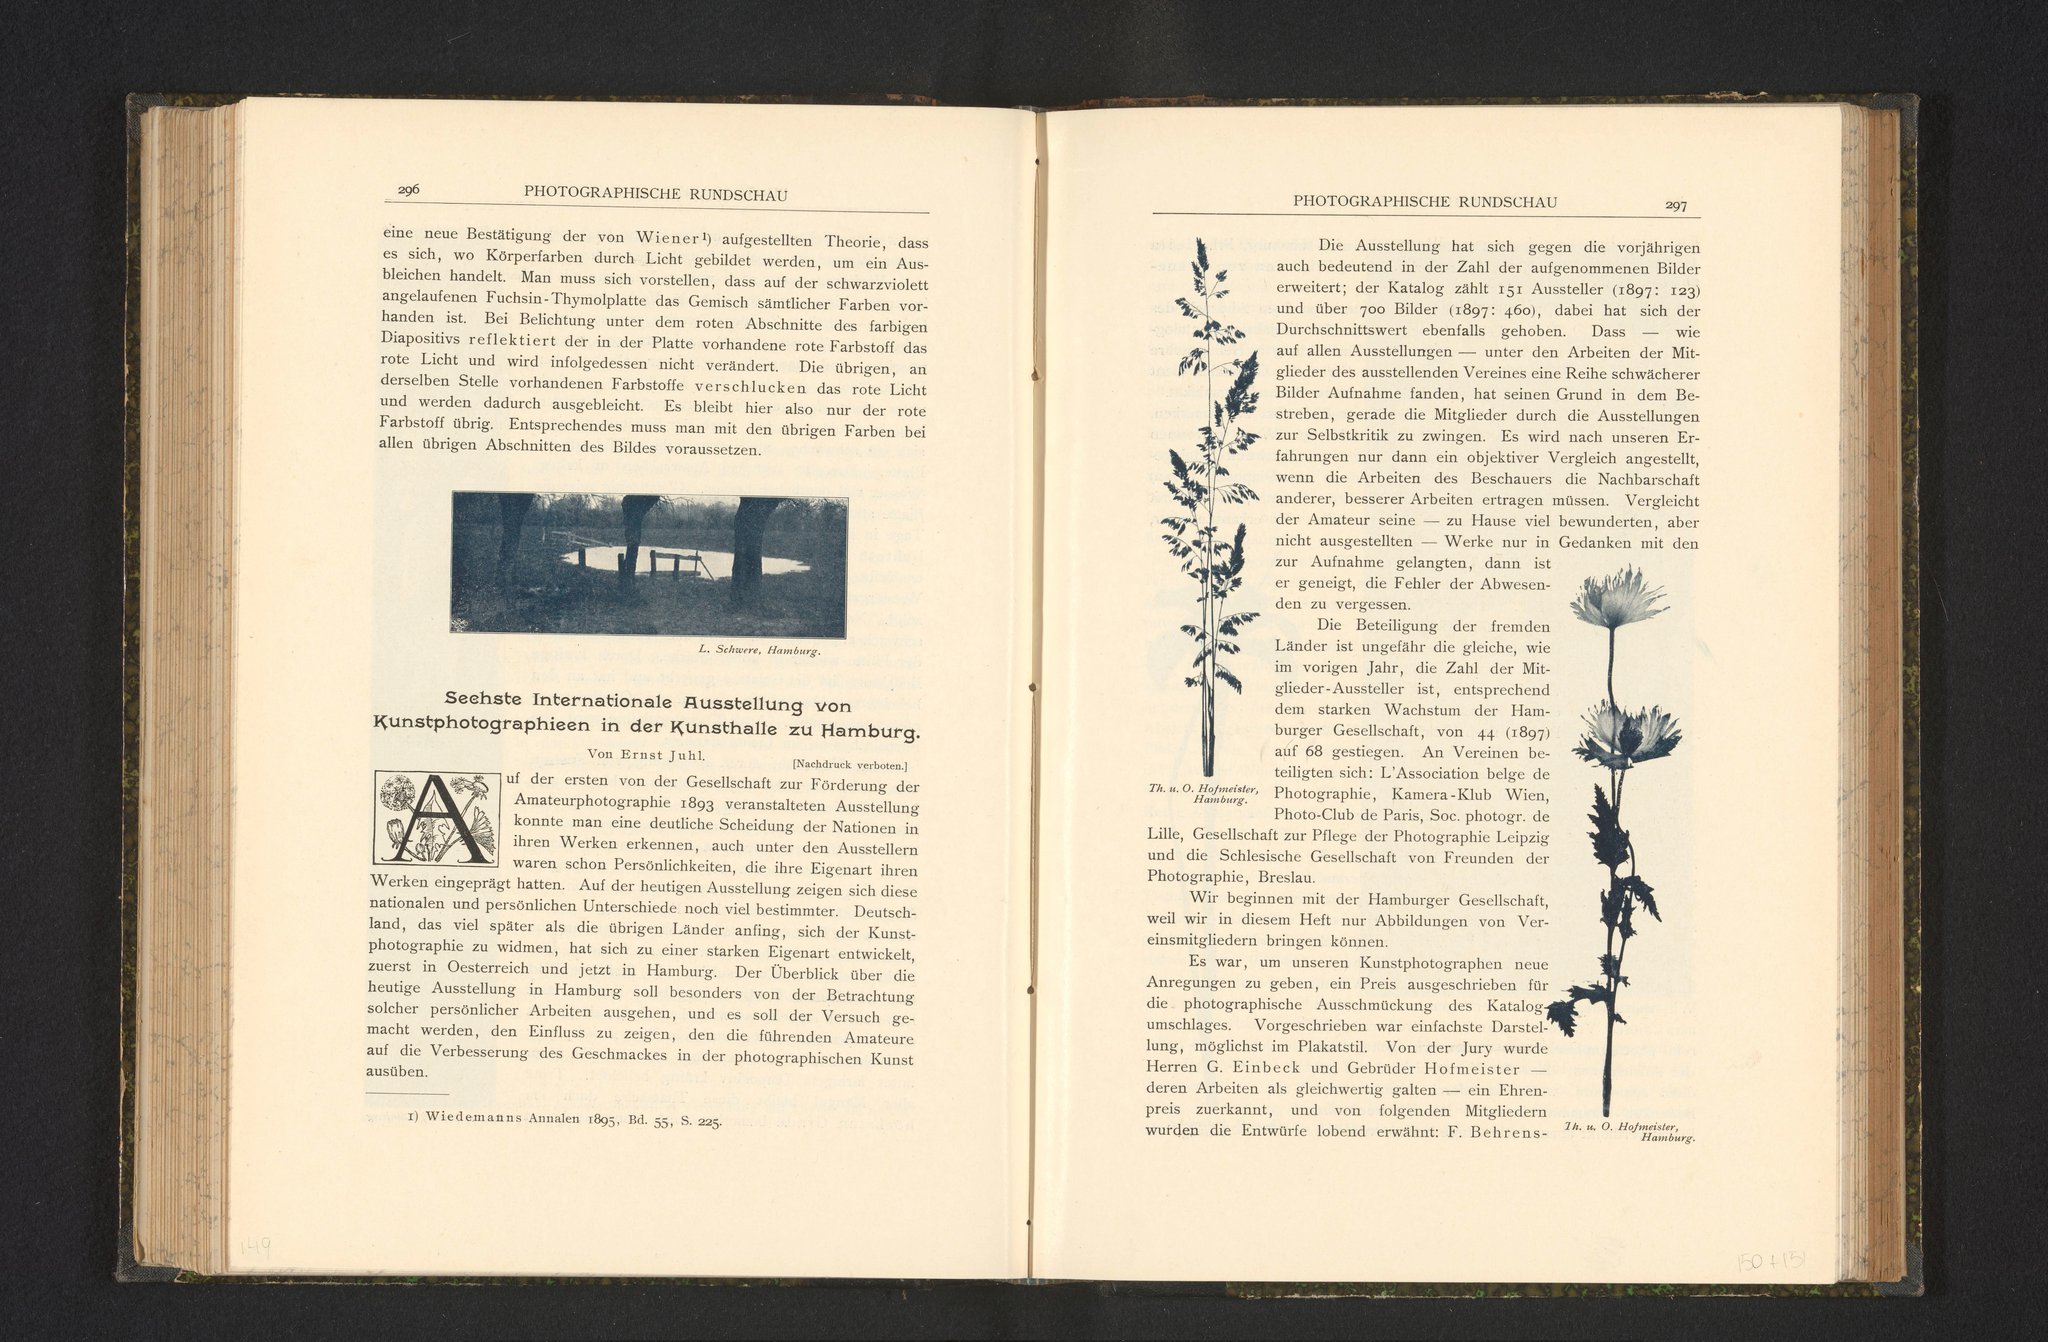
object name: page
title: Plant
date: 1893-1898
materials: paper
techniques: autotype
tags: plants (in general)